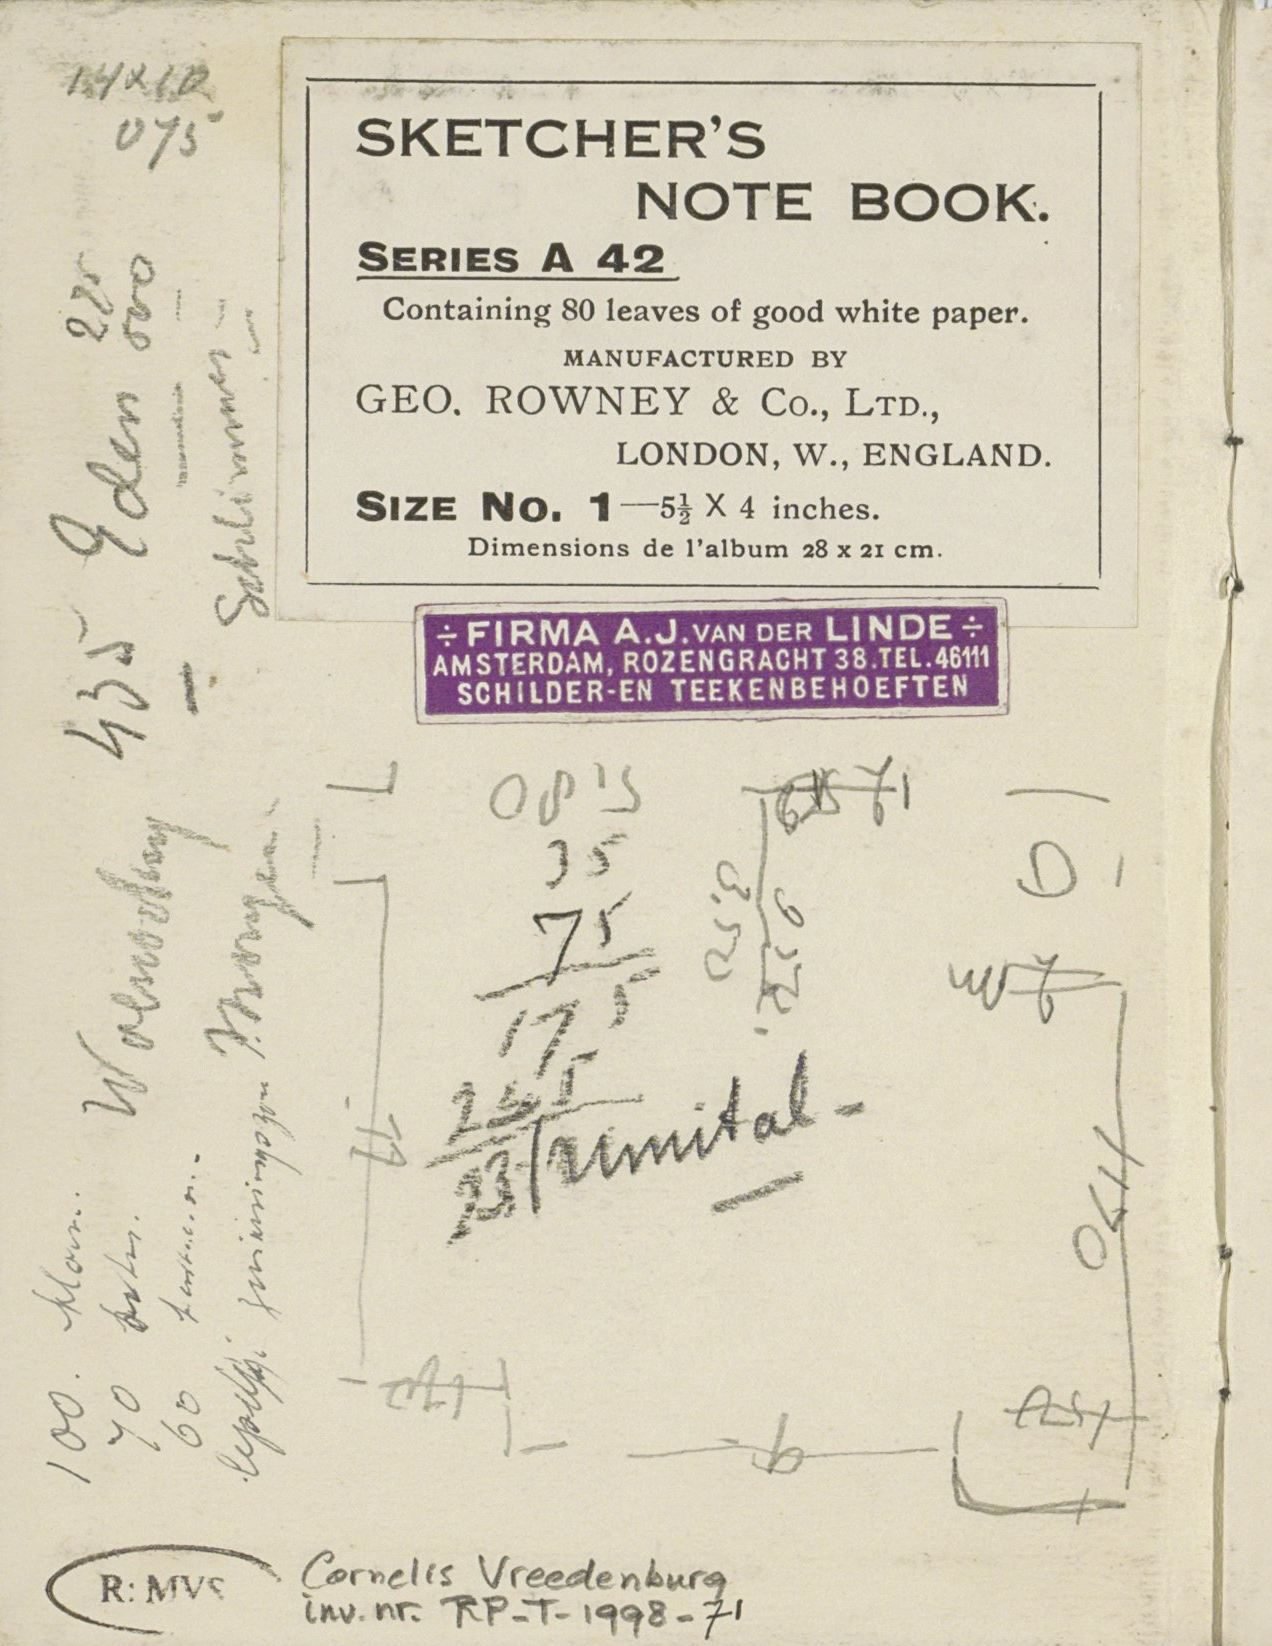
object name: endleaf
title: Notities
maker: cornelis vreedenburgh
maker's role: draughtsman, print maker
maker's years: 1880-1946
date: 1890-1946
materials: chalk, ink, paper, pencil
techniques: pen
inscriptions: factory mark: ‘SKETCHER'S/ NOTE BOOK/ SERIES A 42/ containing 80 leaves of good white paper./ MANUFACTURED BY/ GEO. ROWNEY & CO., LONDON, W., ENGLAND/ SIZE No. 1- 5 1/2 x 4 inches./ Dimensions de l'album 28 x 21 cm.’, retailer's mark: ‘FIRMA A.J. van der LINDE/ AMSTERDAM, ROZENGRACHT 38, TEL.N 6111/ SCHILDER-EN TEEKENBEHOEFTEN’, collector's mark: Lugt 2228a, annotation: ‘[...]’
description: Voorste schutblad uit een schetsboek met 71 bladen.